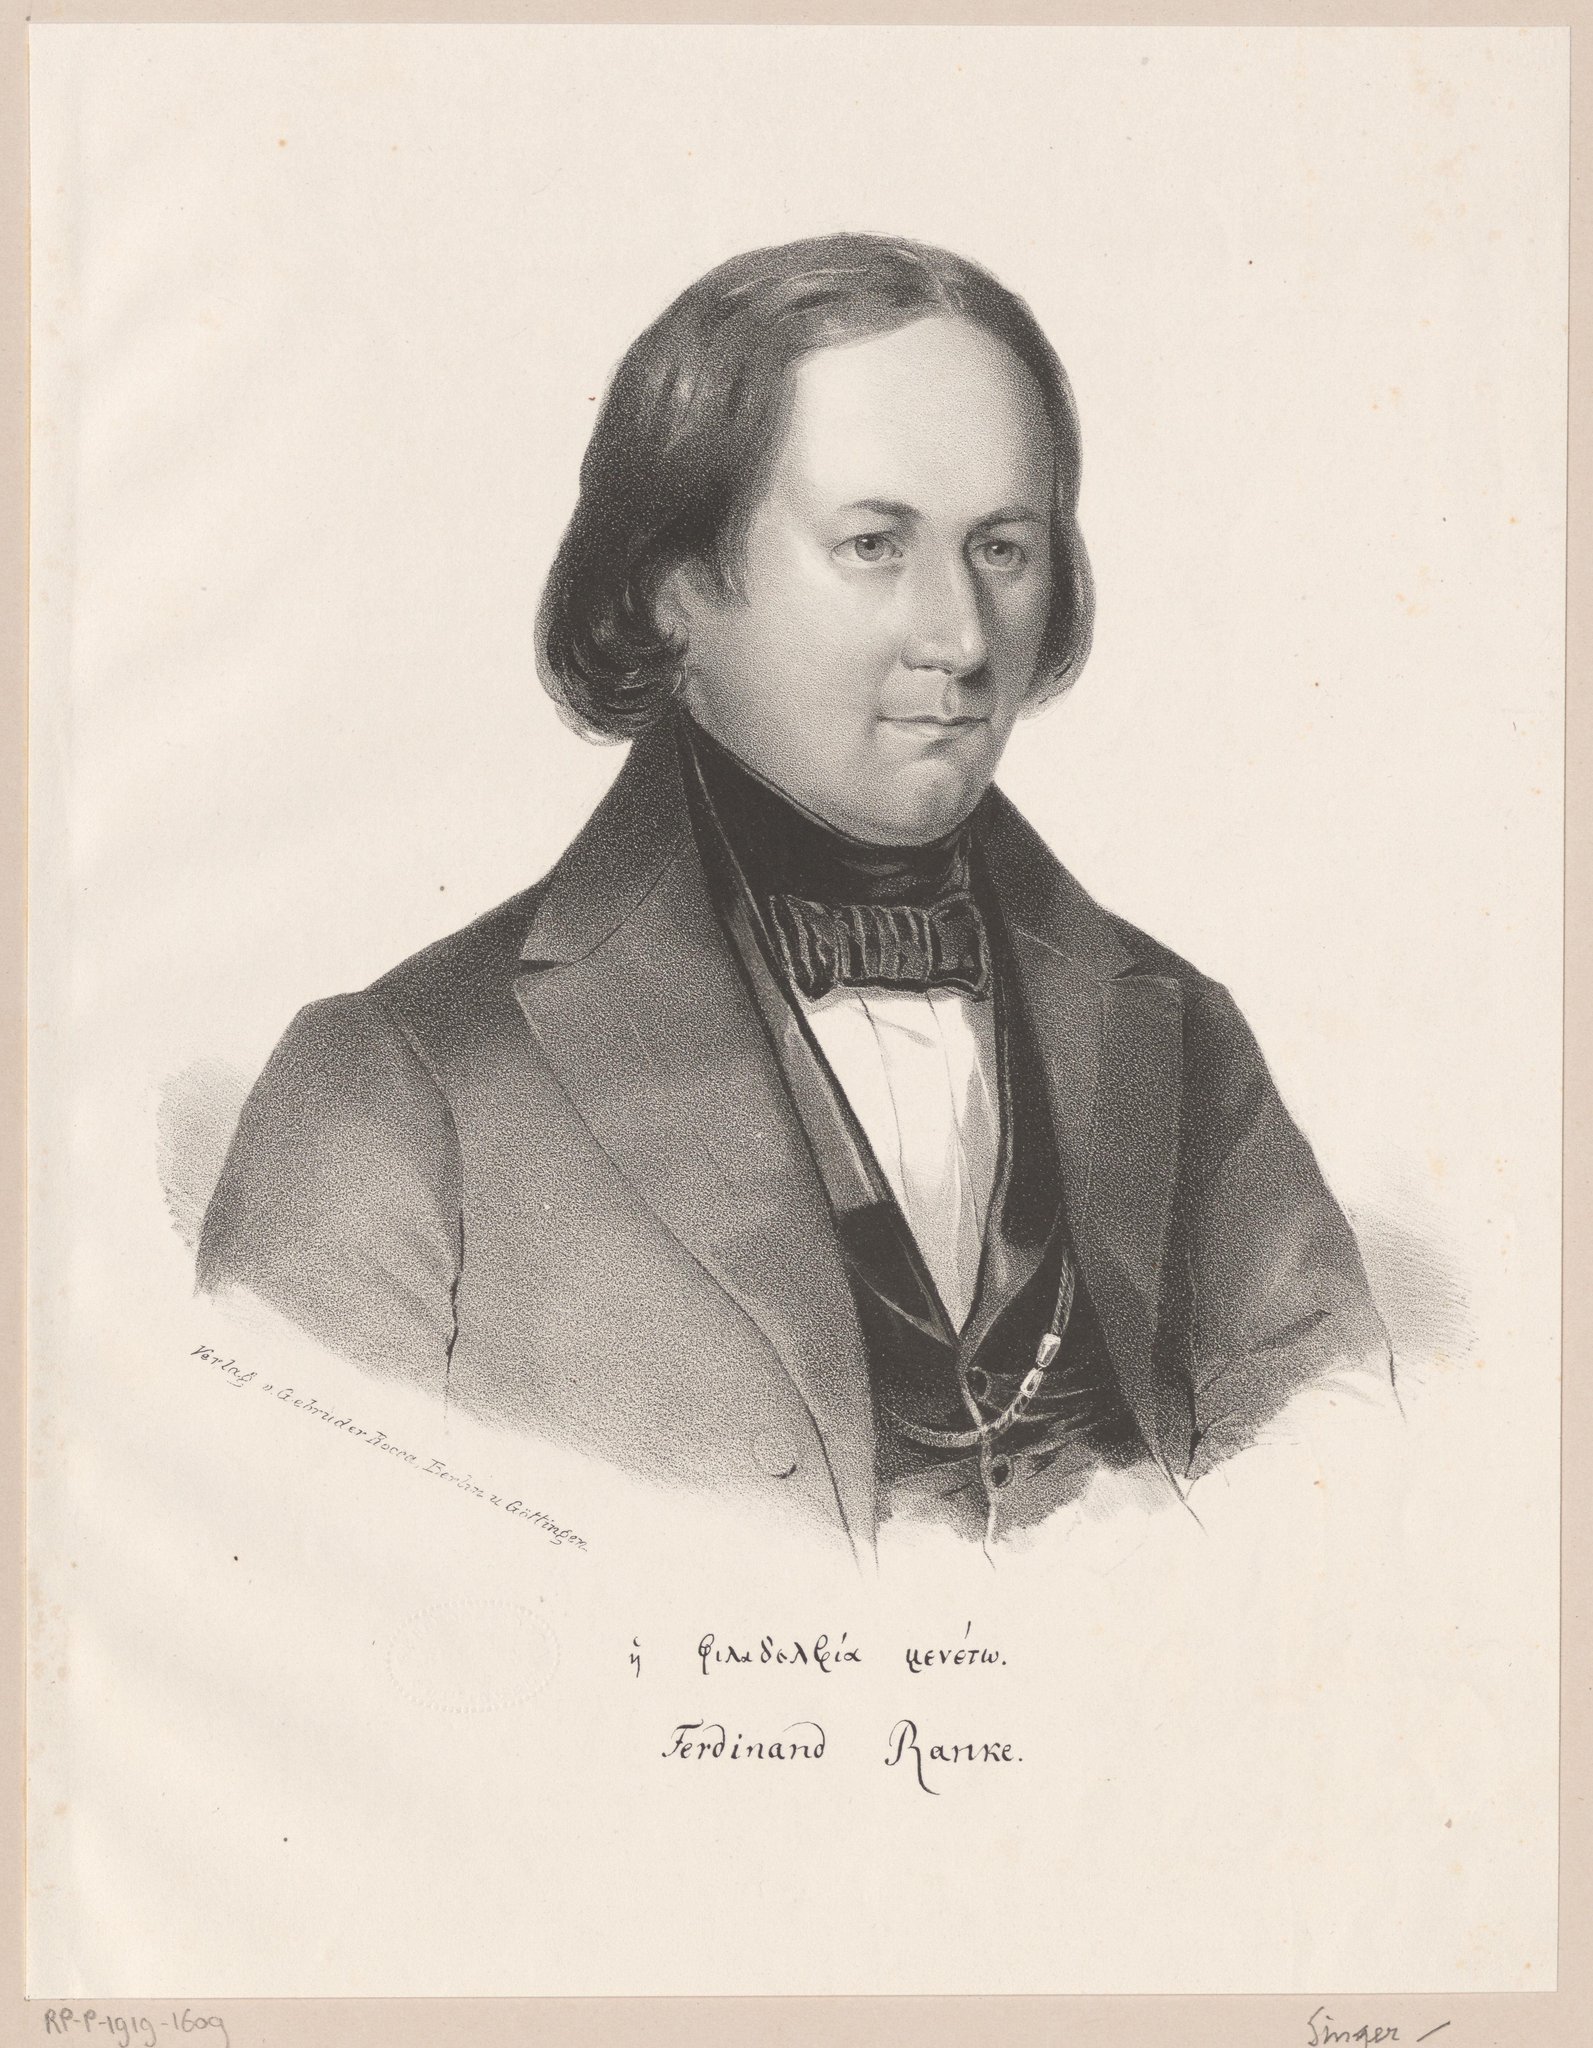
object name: print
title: Portret van Karl Ferdinand Ranke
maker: Anonymous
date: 1830-1863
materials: paper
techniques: lithograph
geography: berlin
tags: berlin, historical persons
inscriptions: collector's mark: Lugt 2228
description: Onder het portret een facsimile van de handtekening van de geportretteerde.